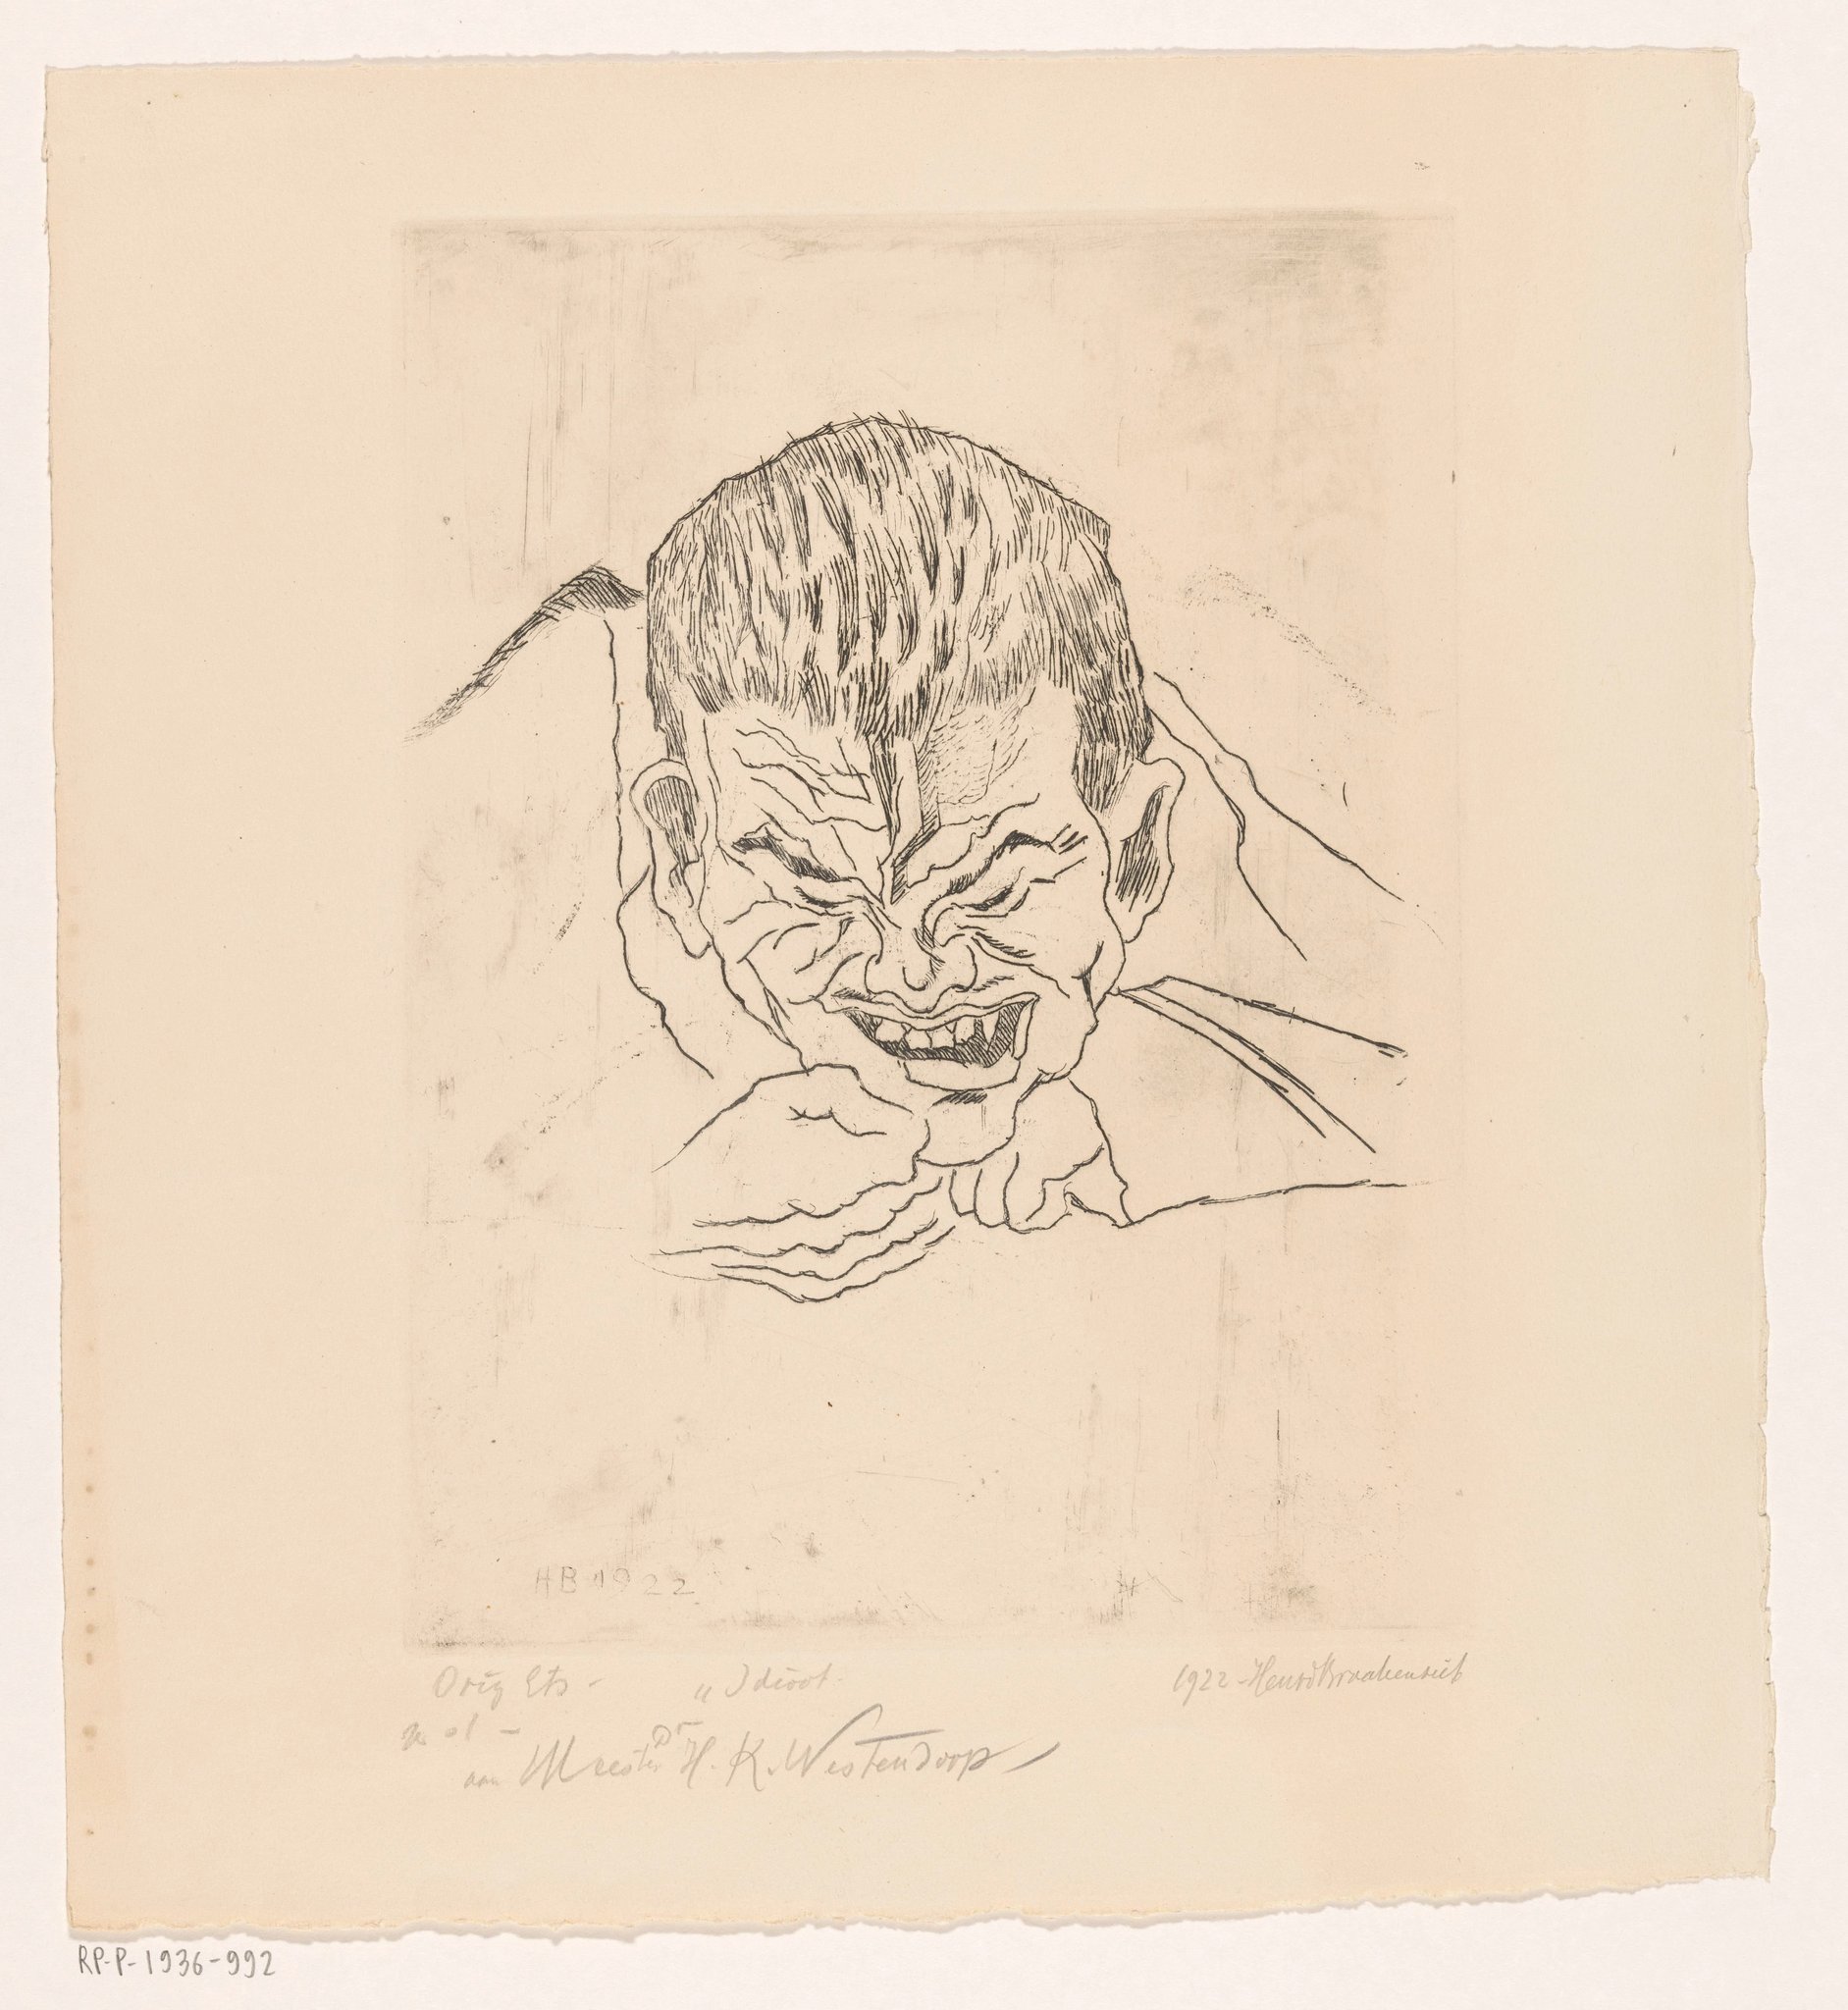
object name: print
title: Idioot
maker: henri braakensiek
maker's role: print maker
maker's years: 1891-1941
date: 1922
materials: paper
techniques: etching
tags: teeth, mouth slightly open, anonymous historical person portrayed alone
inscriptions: collector's mark: Lugt 2228, inscription: ‘aan Meester Dr. H.K. Westendorp’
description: Een man met geopende mond en een scheef gebit.